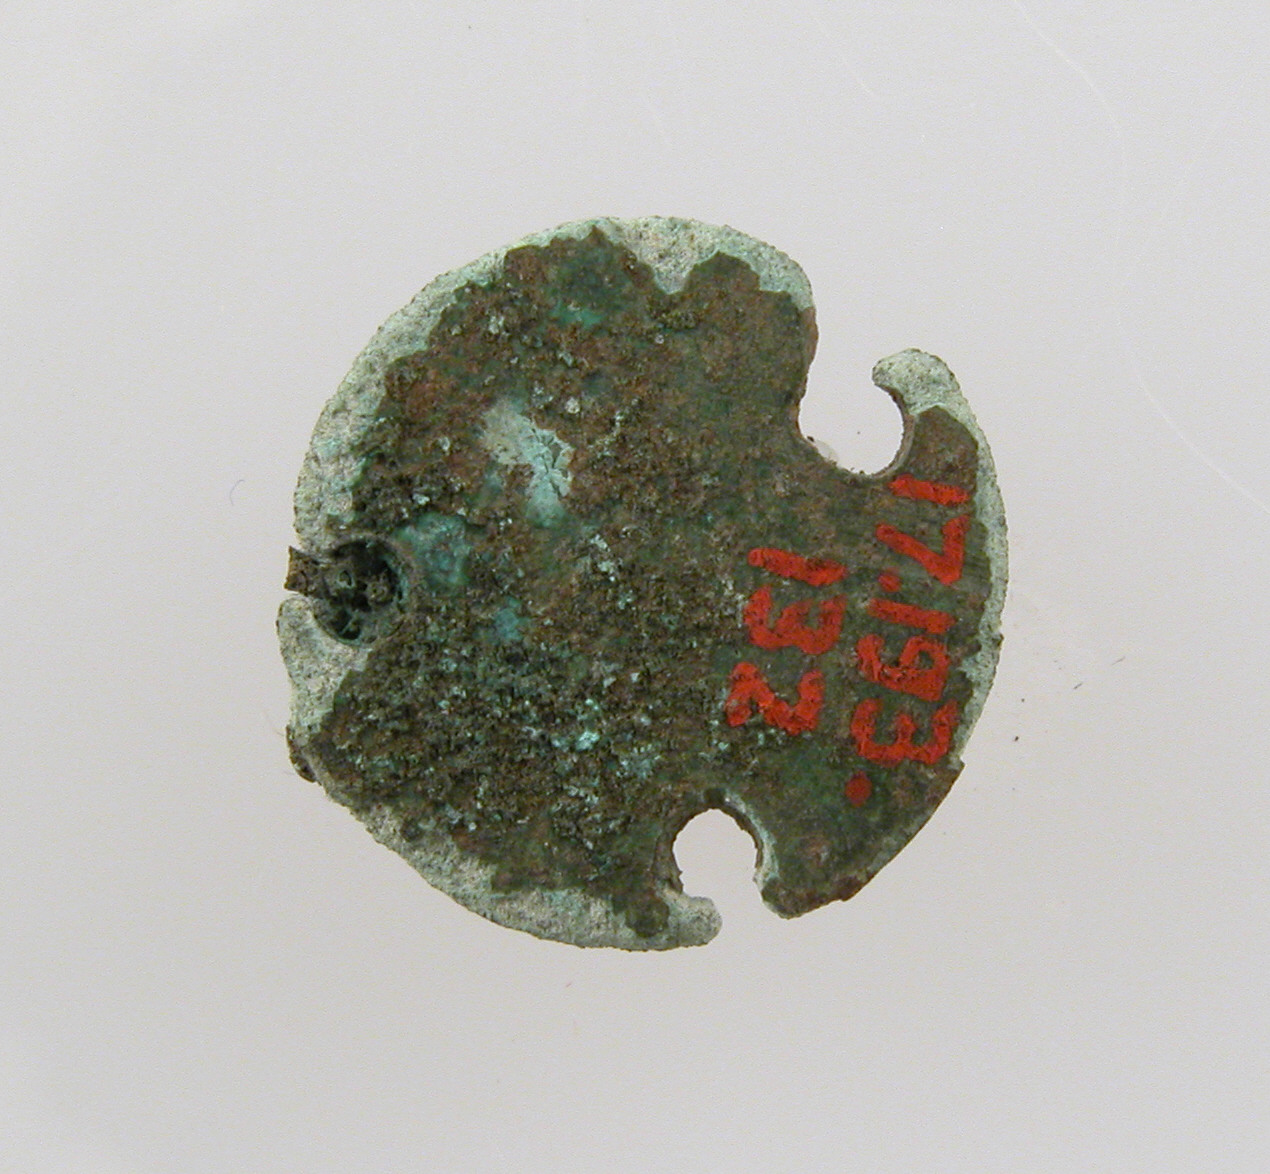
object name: belt fitting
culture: frankish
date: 501-700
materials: copper alloy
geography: germany